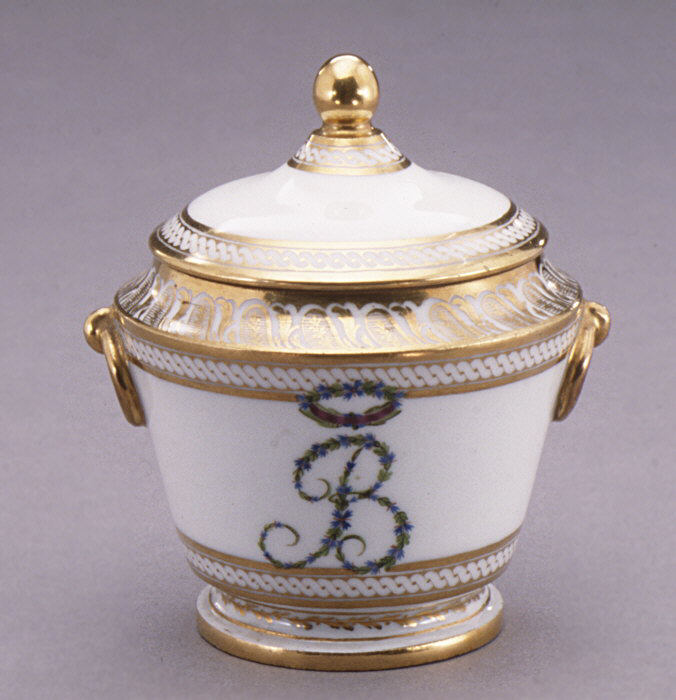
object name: sugar bowl with cover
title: Sugar bowl with cover (part of a traveling tea service)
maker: dihl et guérhard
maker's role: factory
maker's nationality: french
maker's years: 1781-1824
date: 1788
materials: hard paste porcelain